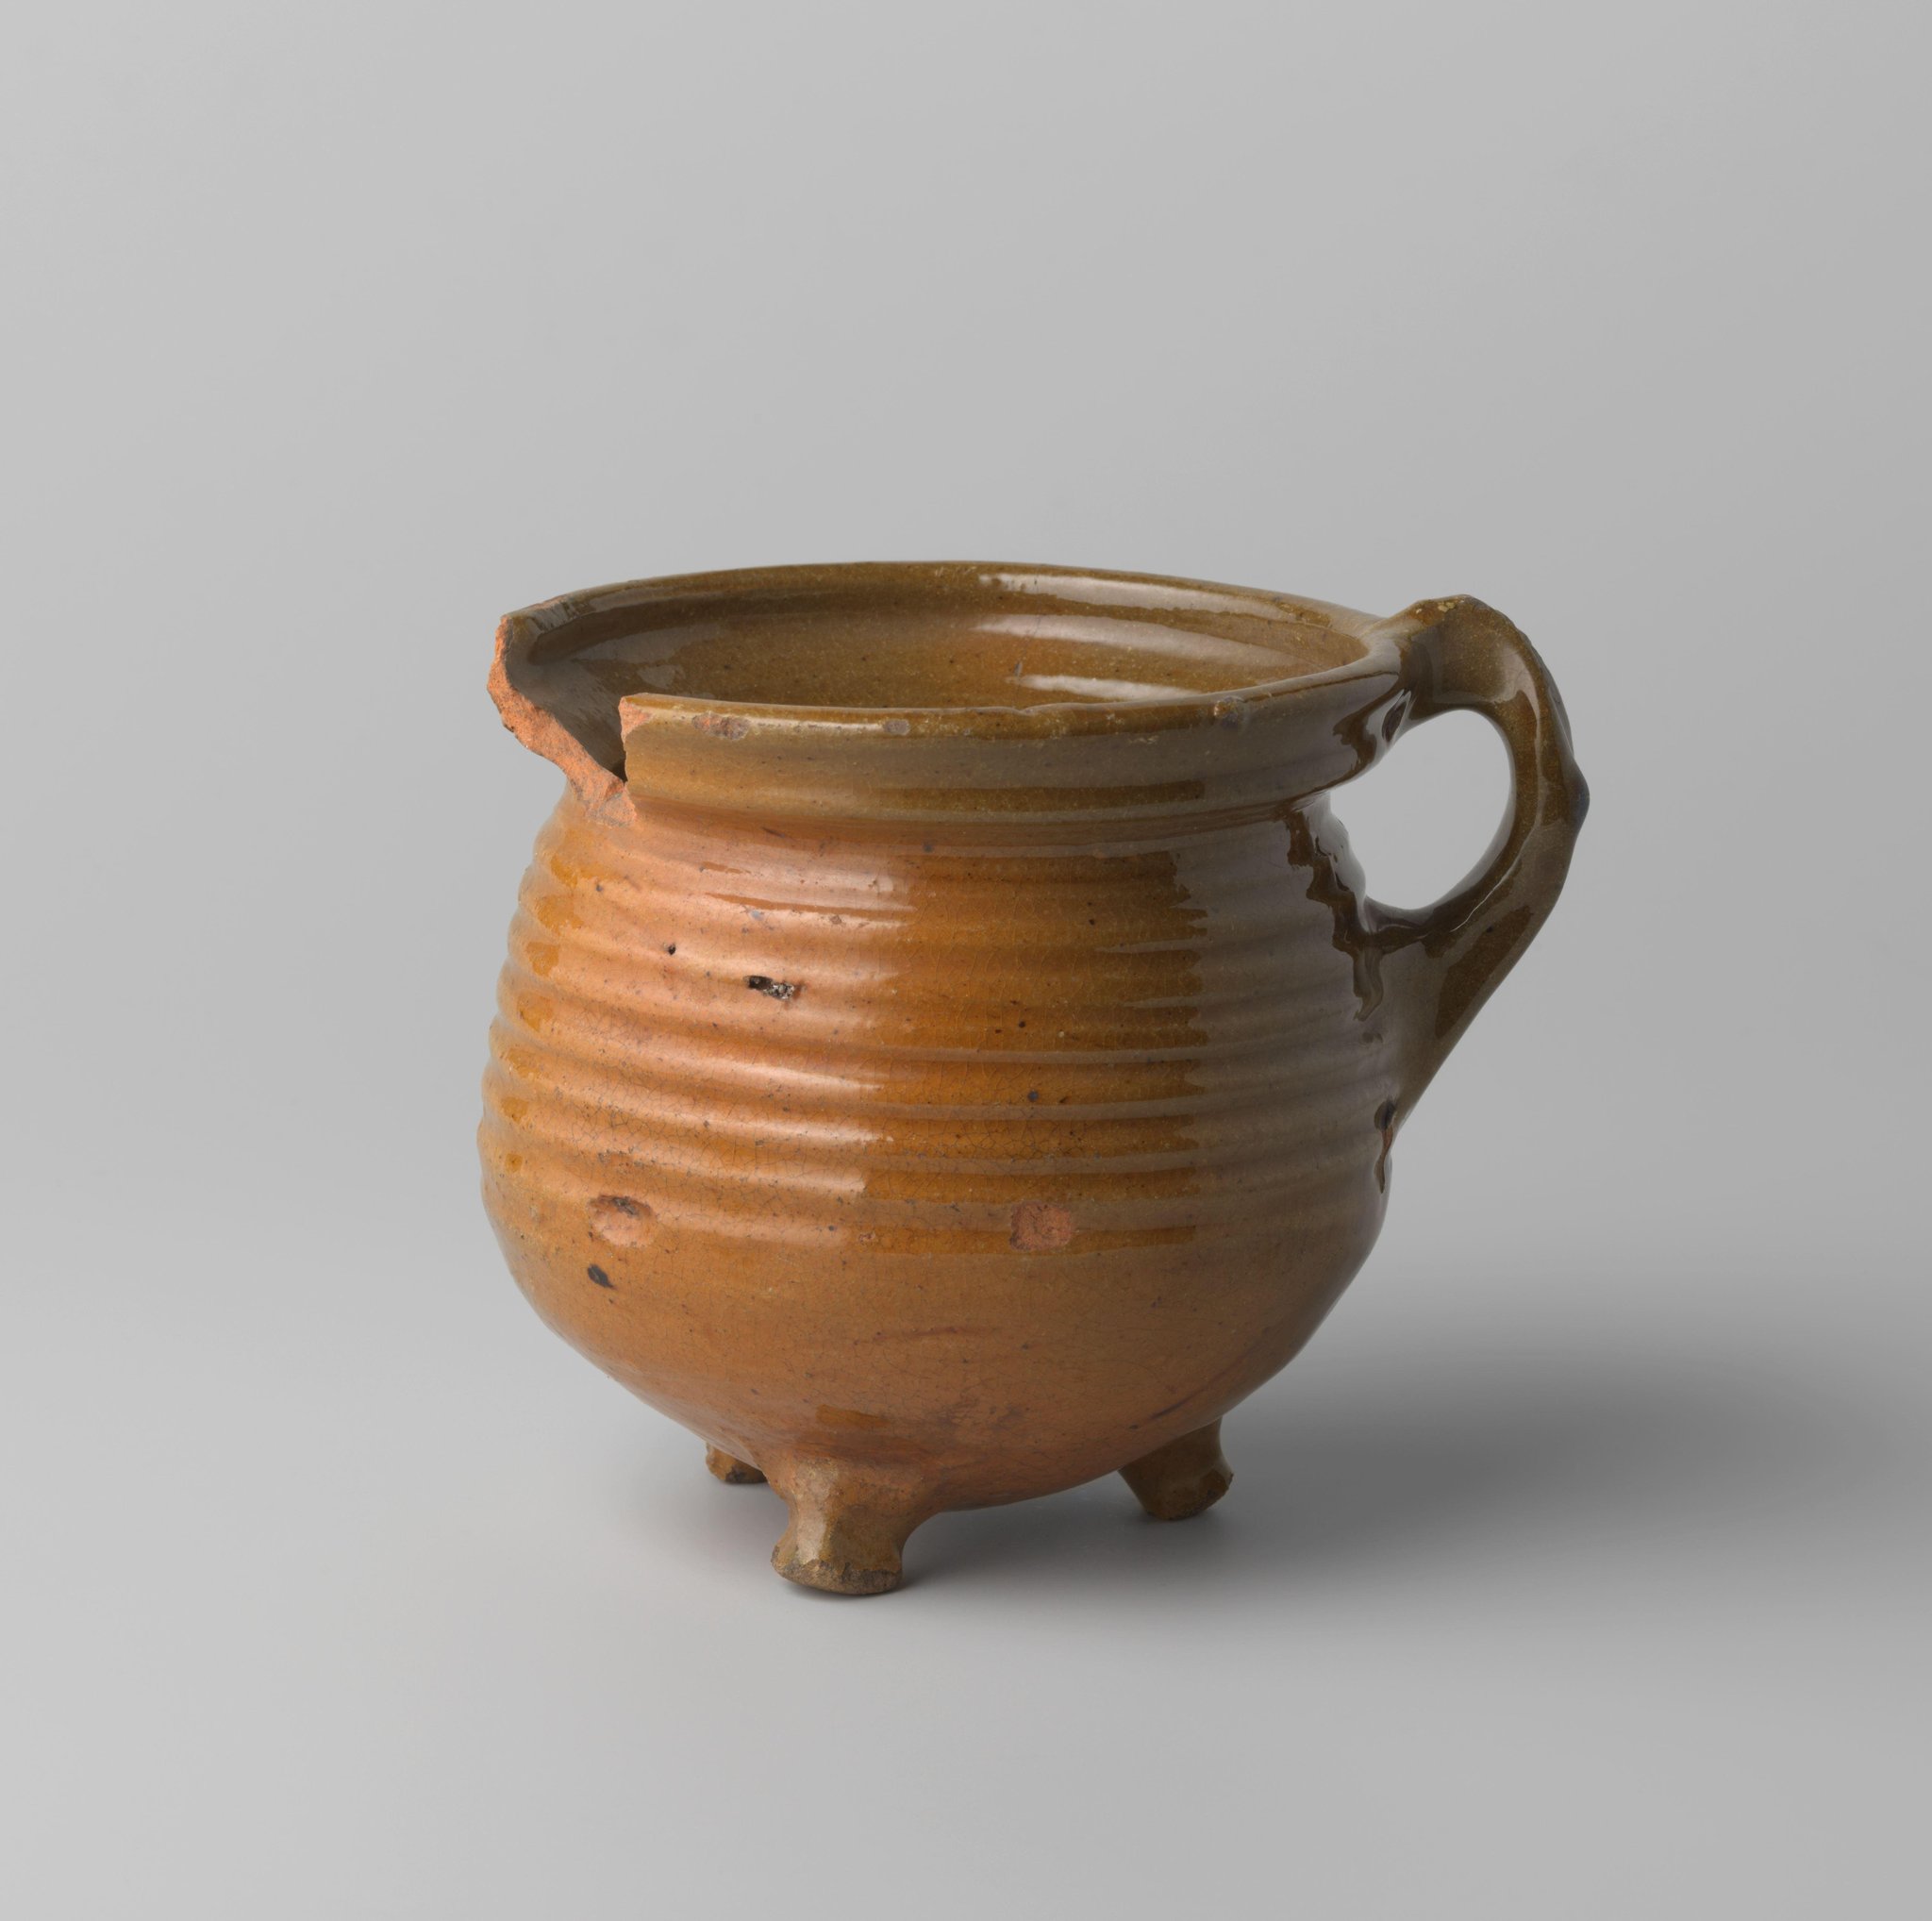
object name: cauldron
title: Kookpot van roodbakkend aardewerk, op 3 poten, met oor, aan de binnen- en buitenzijde voorzien van glazuur, rand beschadigd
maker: Anonymous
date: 1500-1799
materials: earthenware, glaze